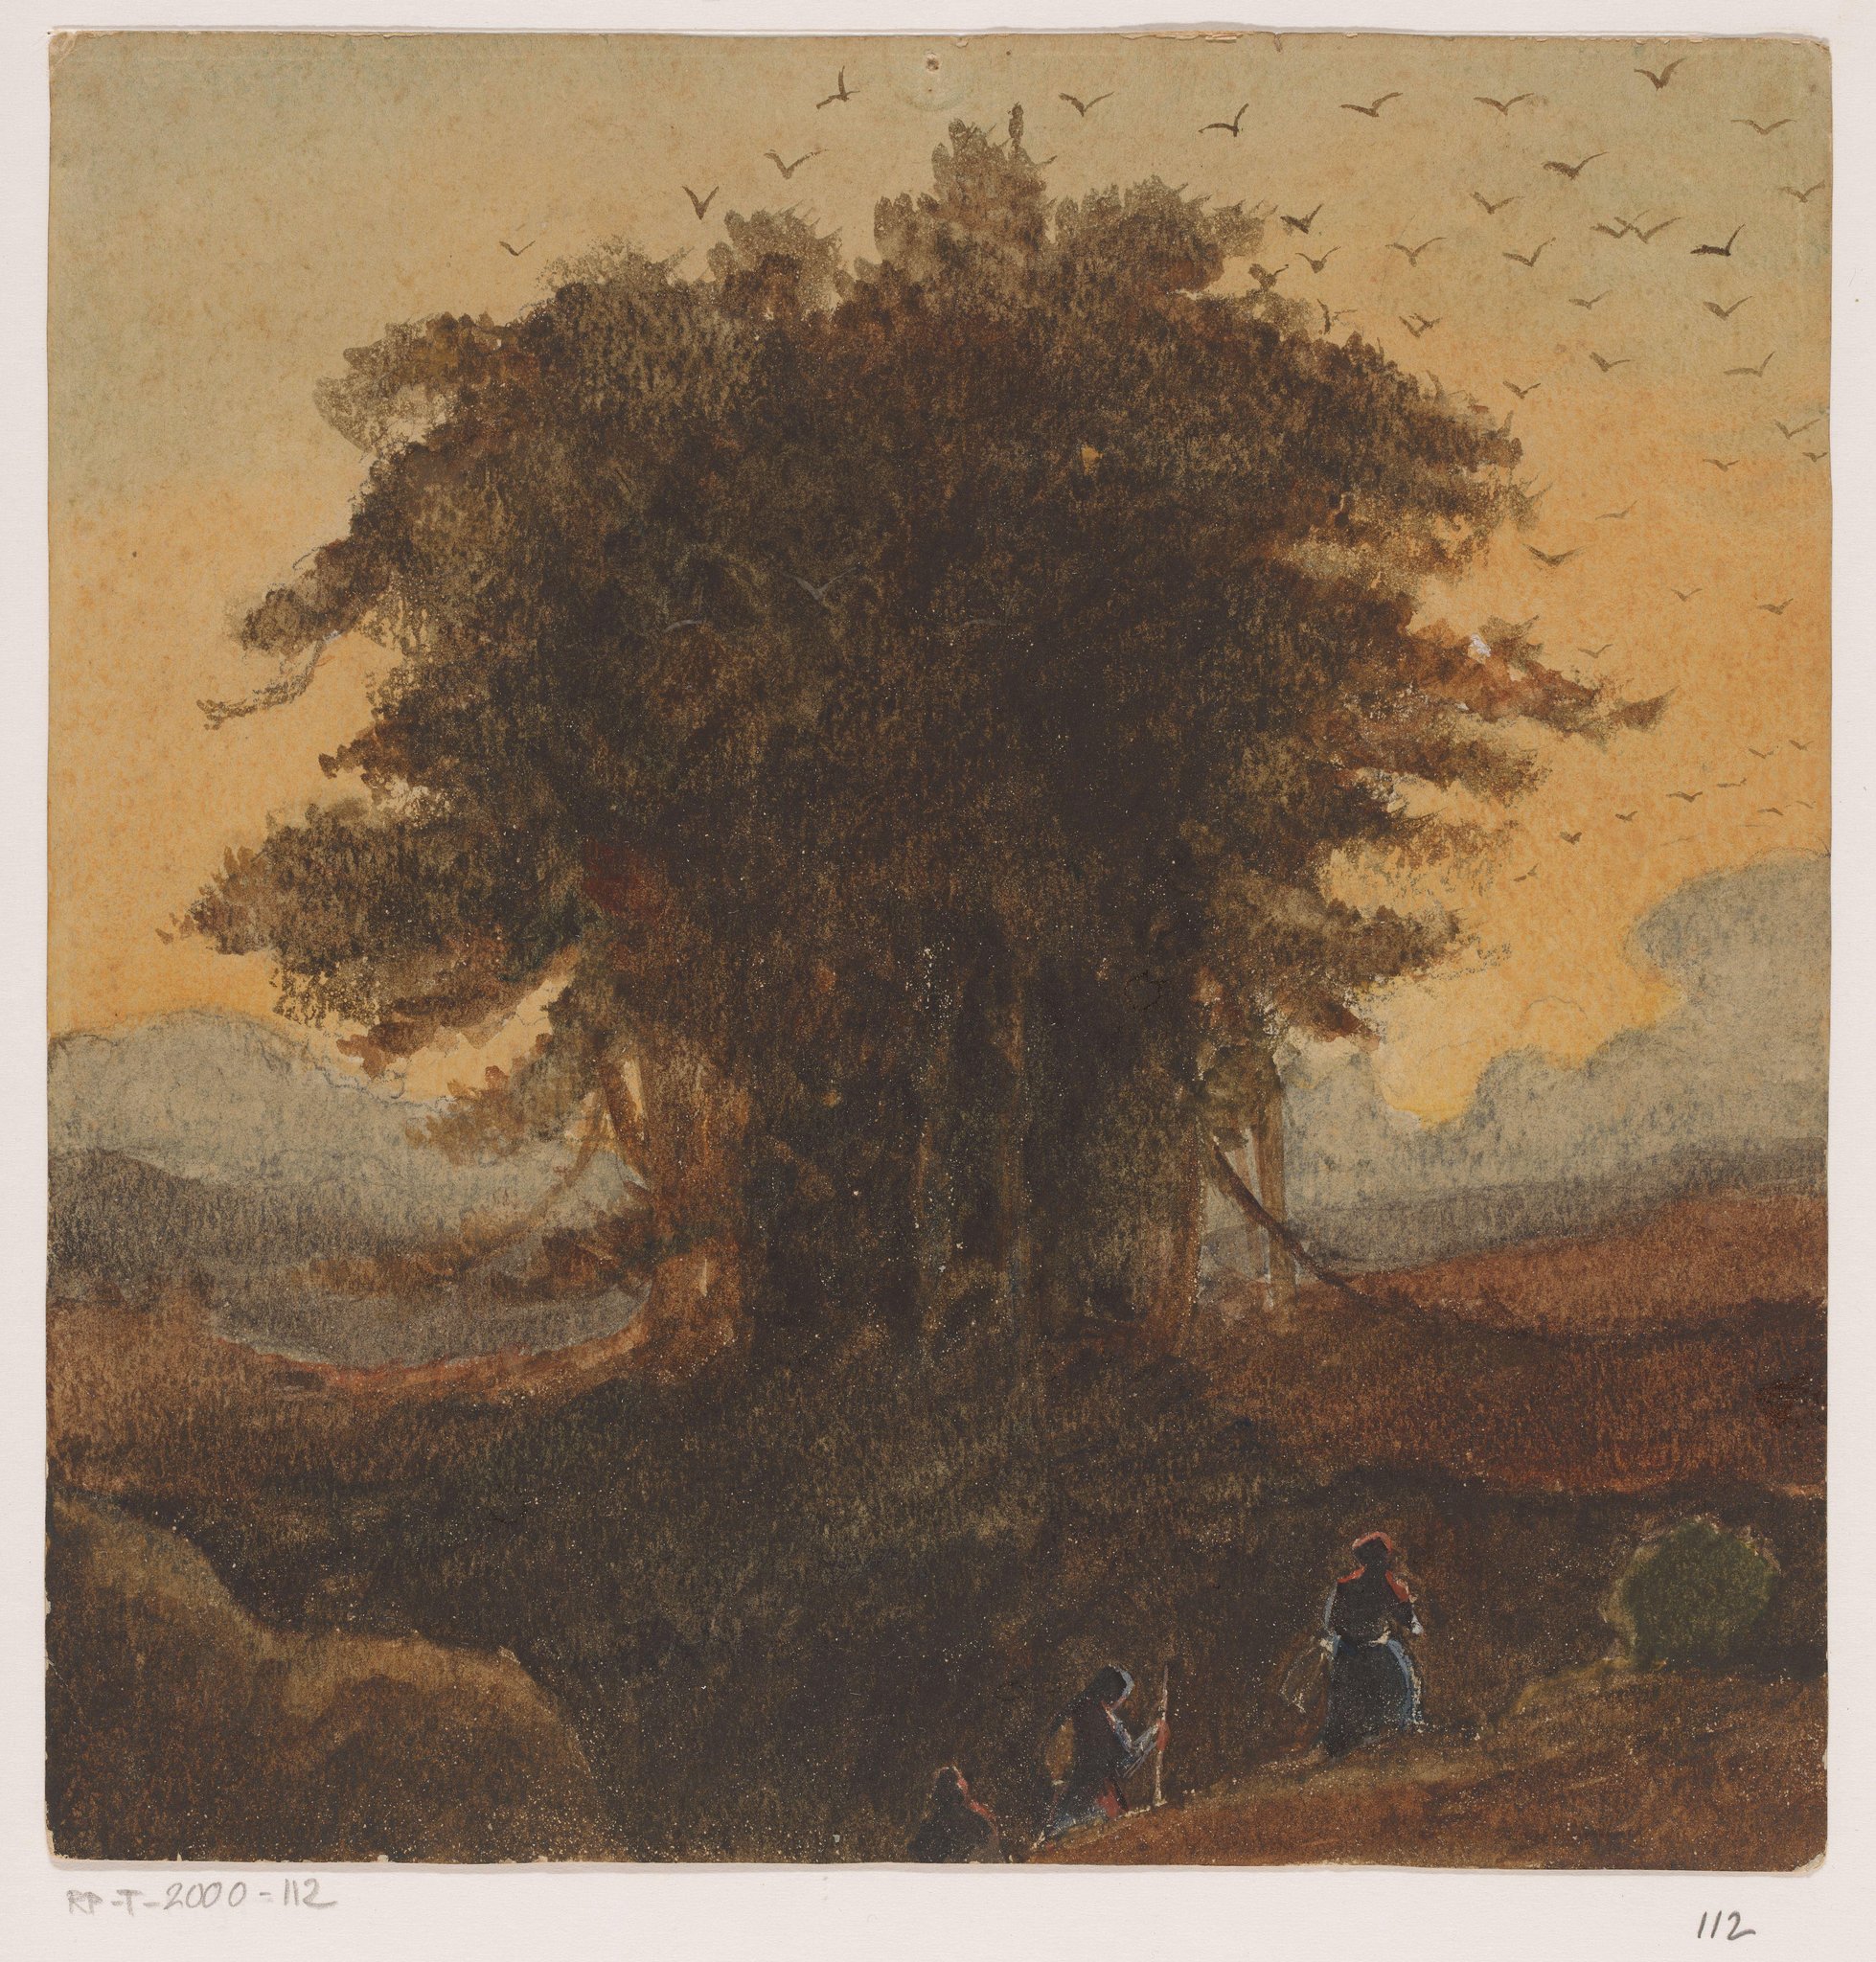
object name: watercolor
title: De boom met vele vogels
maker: johannes tavenraat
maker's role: draughtsman, painter, print maker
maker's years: 1809-1881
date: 1819-1881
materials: paper, watercolor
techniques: brush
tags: hunting, chase, birds, groups of trees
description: Groep bomen waaruit een zwerm vogels opvliegt, op de voorgrond enkele jagers.